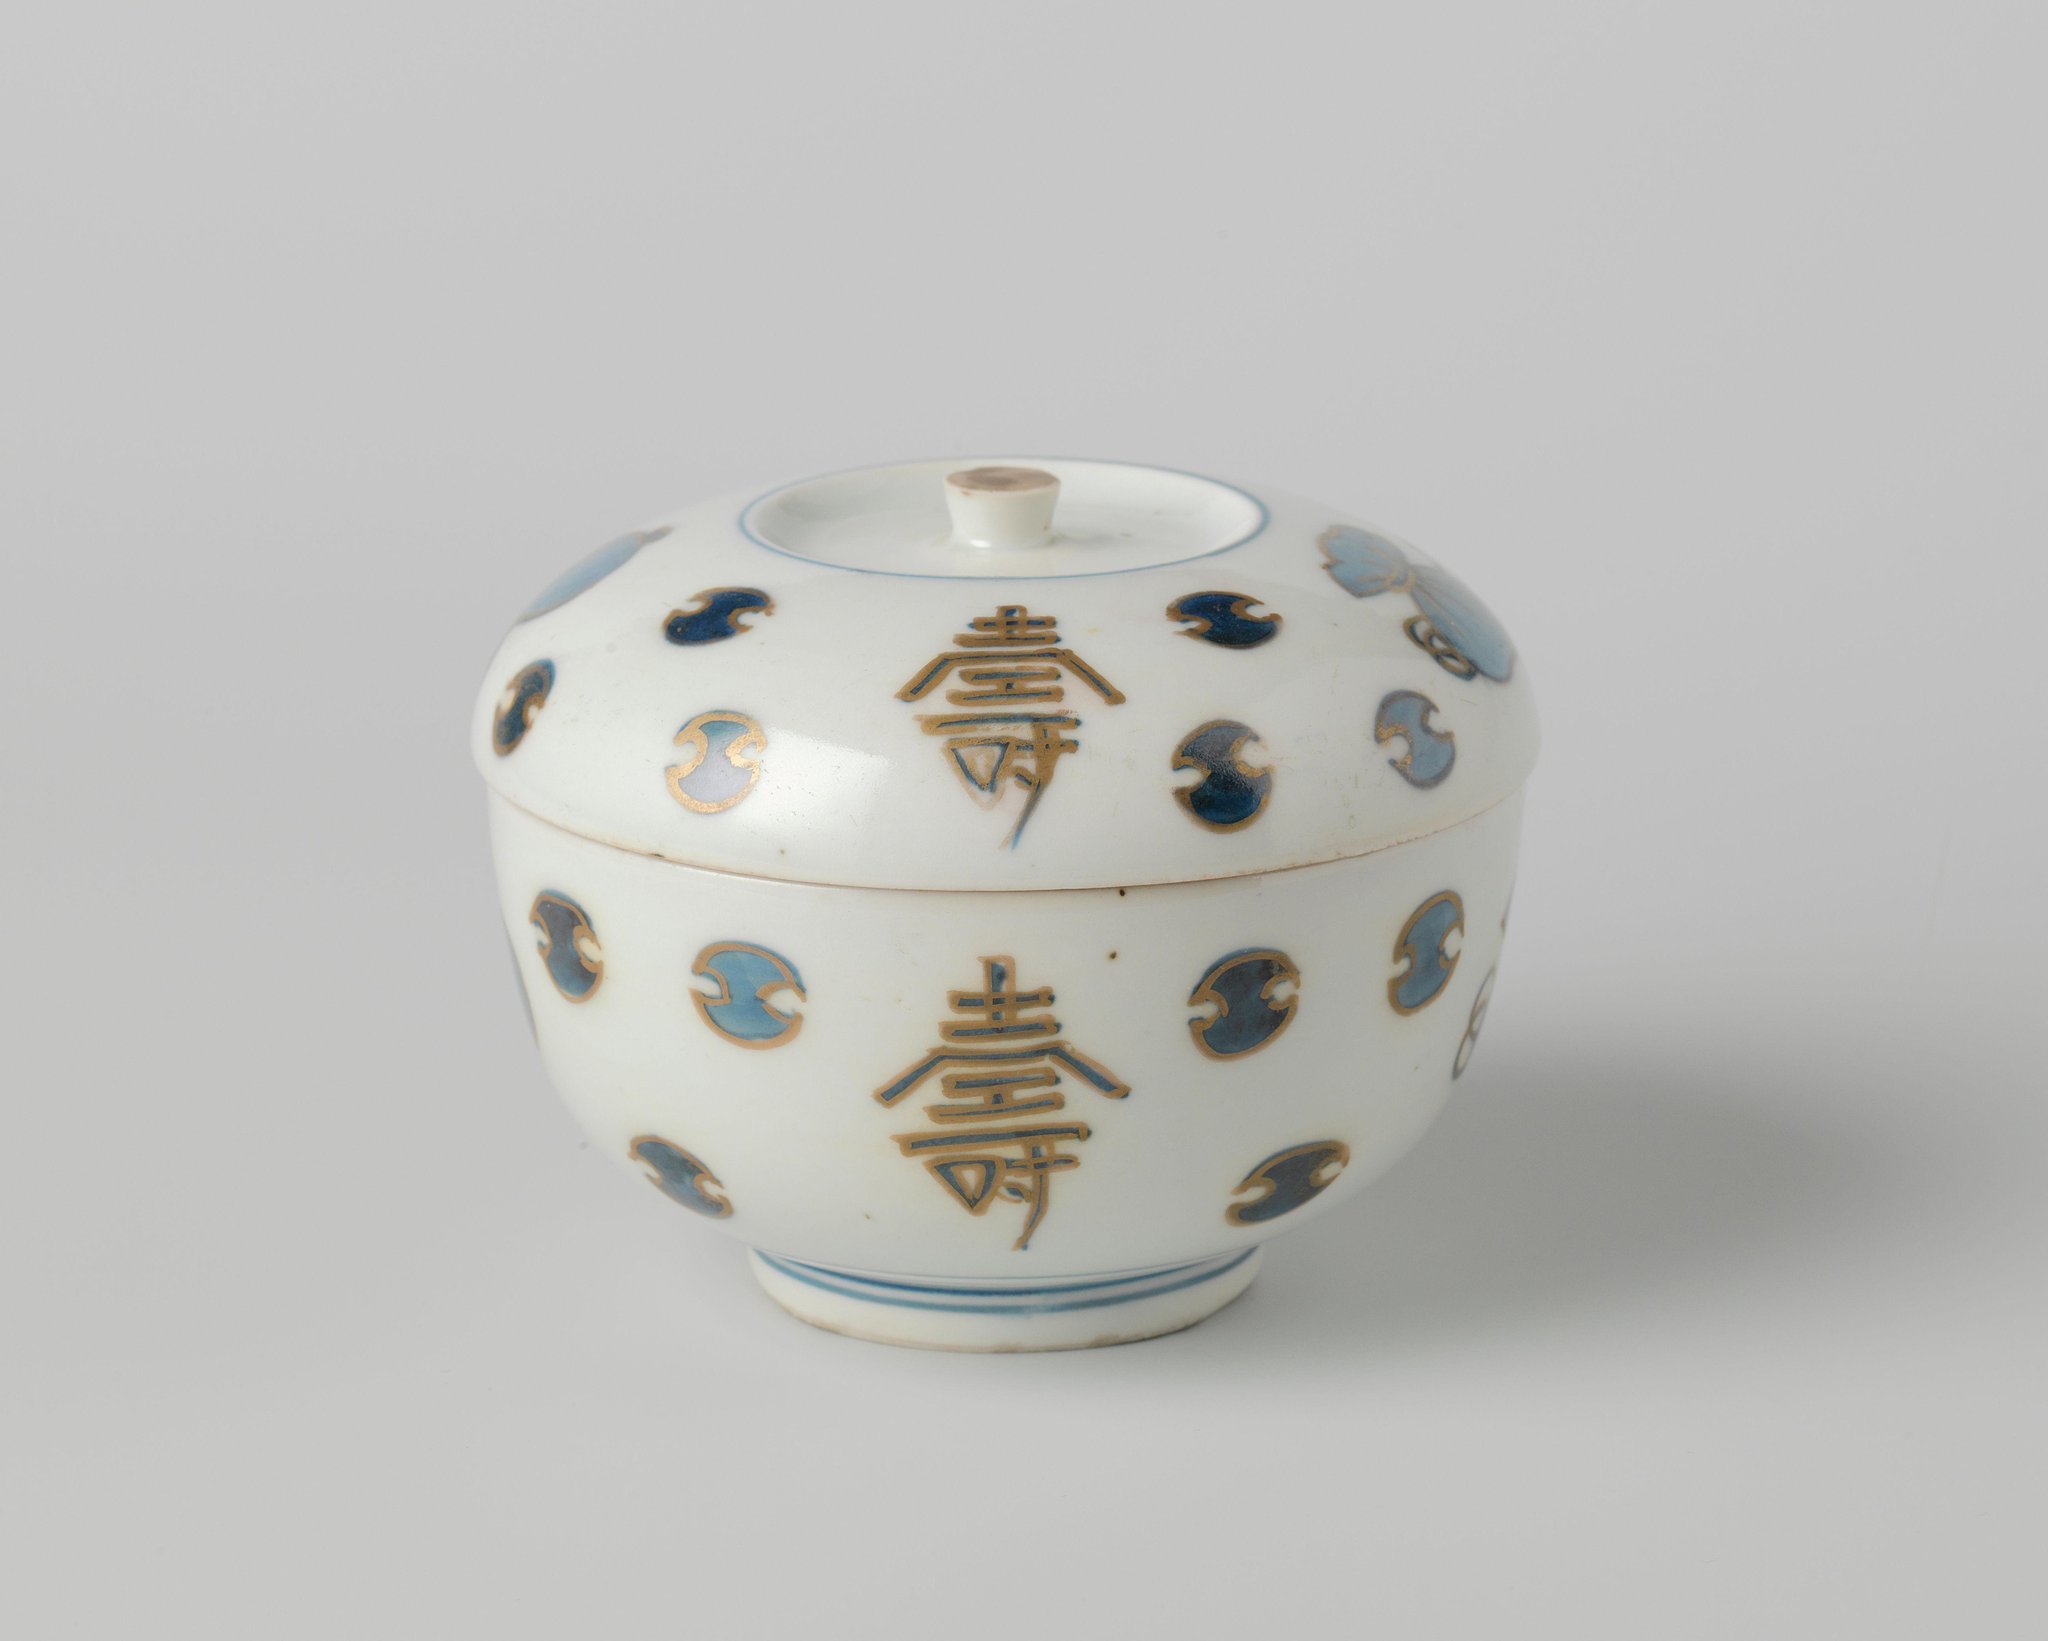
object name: box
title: Box with carachters and auspicious symbols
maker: Anonymous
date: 1800-1830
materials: cobalt, glaze, gold, paint, porcelain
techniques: firing, gilding, turning, vitrification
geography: japan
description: Doos van porselein, beschilderd in onderglazuur blauw en op het glazuur aubergine, turquoise, zwart en goud. De buitenwand van de doos met gelukssymbolen (hamer, buidel, munten) en twee karakters (geluk en voorspoed, lang leven). Op de bodem schelpen.